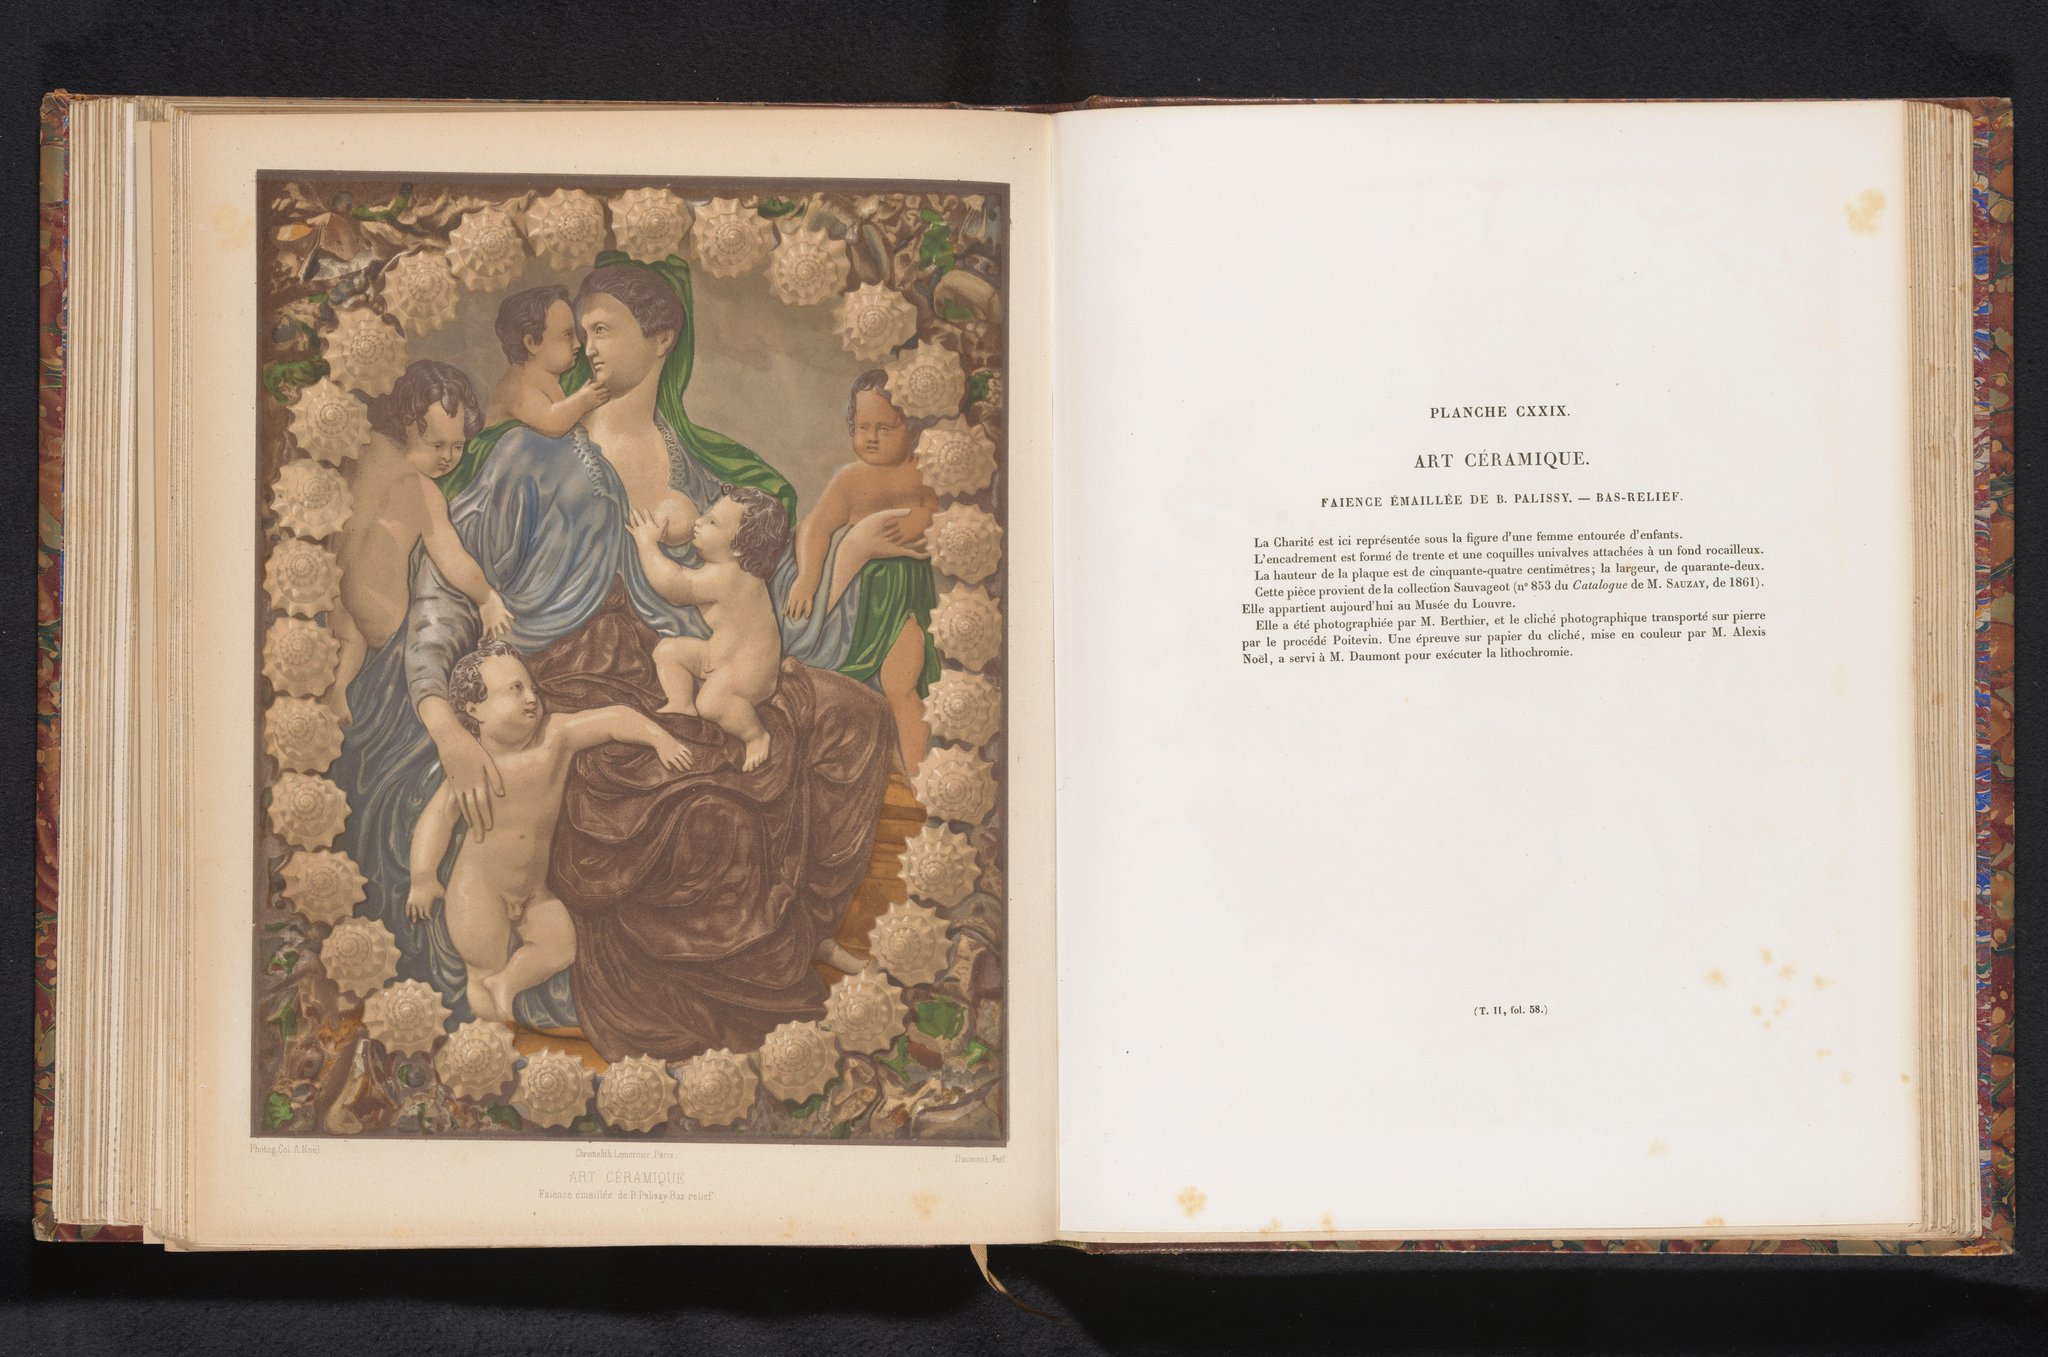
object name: page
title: Faïence émaillée de B. Palissy-Bas-relief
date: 1859-1864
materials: paper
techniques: chromolithography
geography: paris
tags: adult woman, child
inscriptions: name: ‘Phot. col. A. Noël./ Daumont Perf’